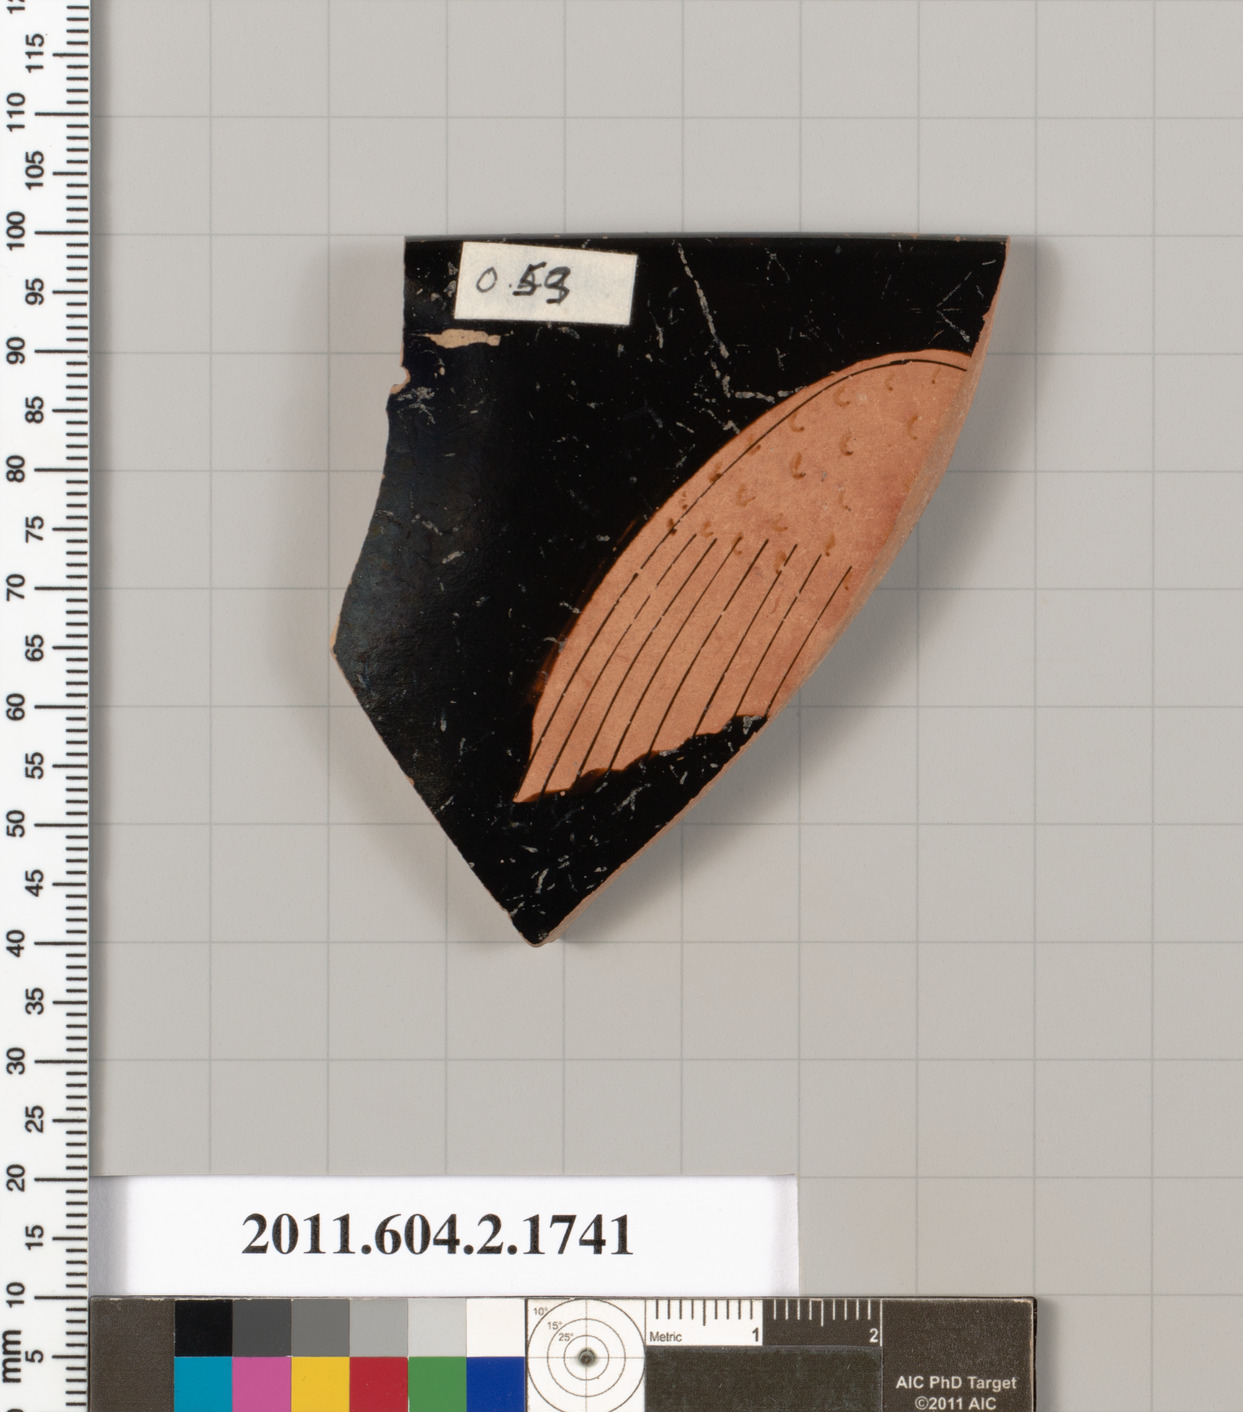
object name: skyphos fragment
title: Terracotta rim fragment of a skyphos (deep drinking cup)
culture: greek, attic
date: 460-450 BCE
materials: terracotta